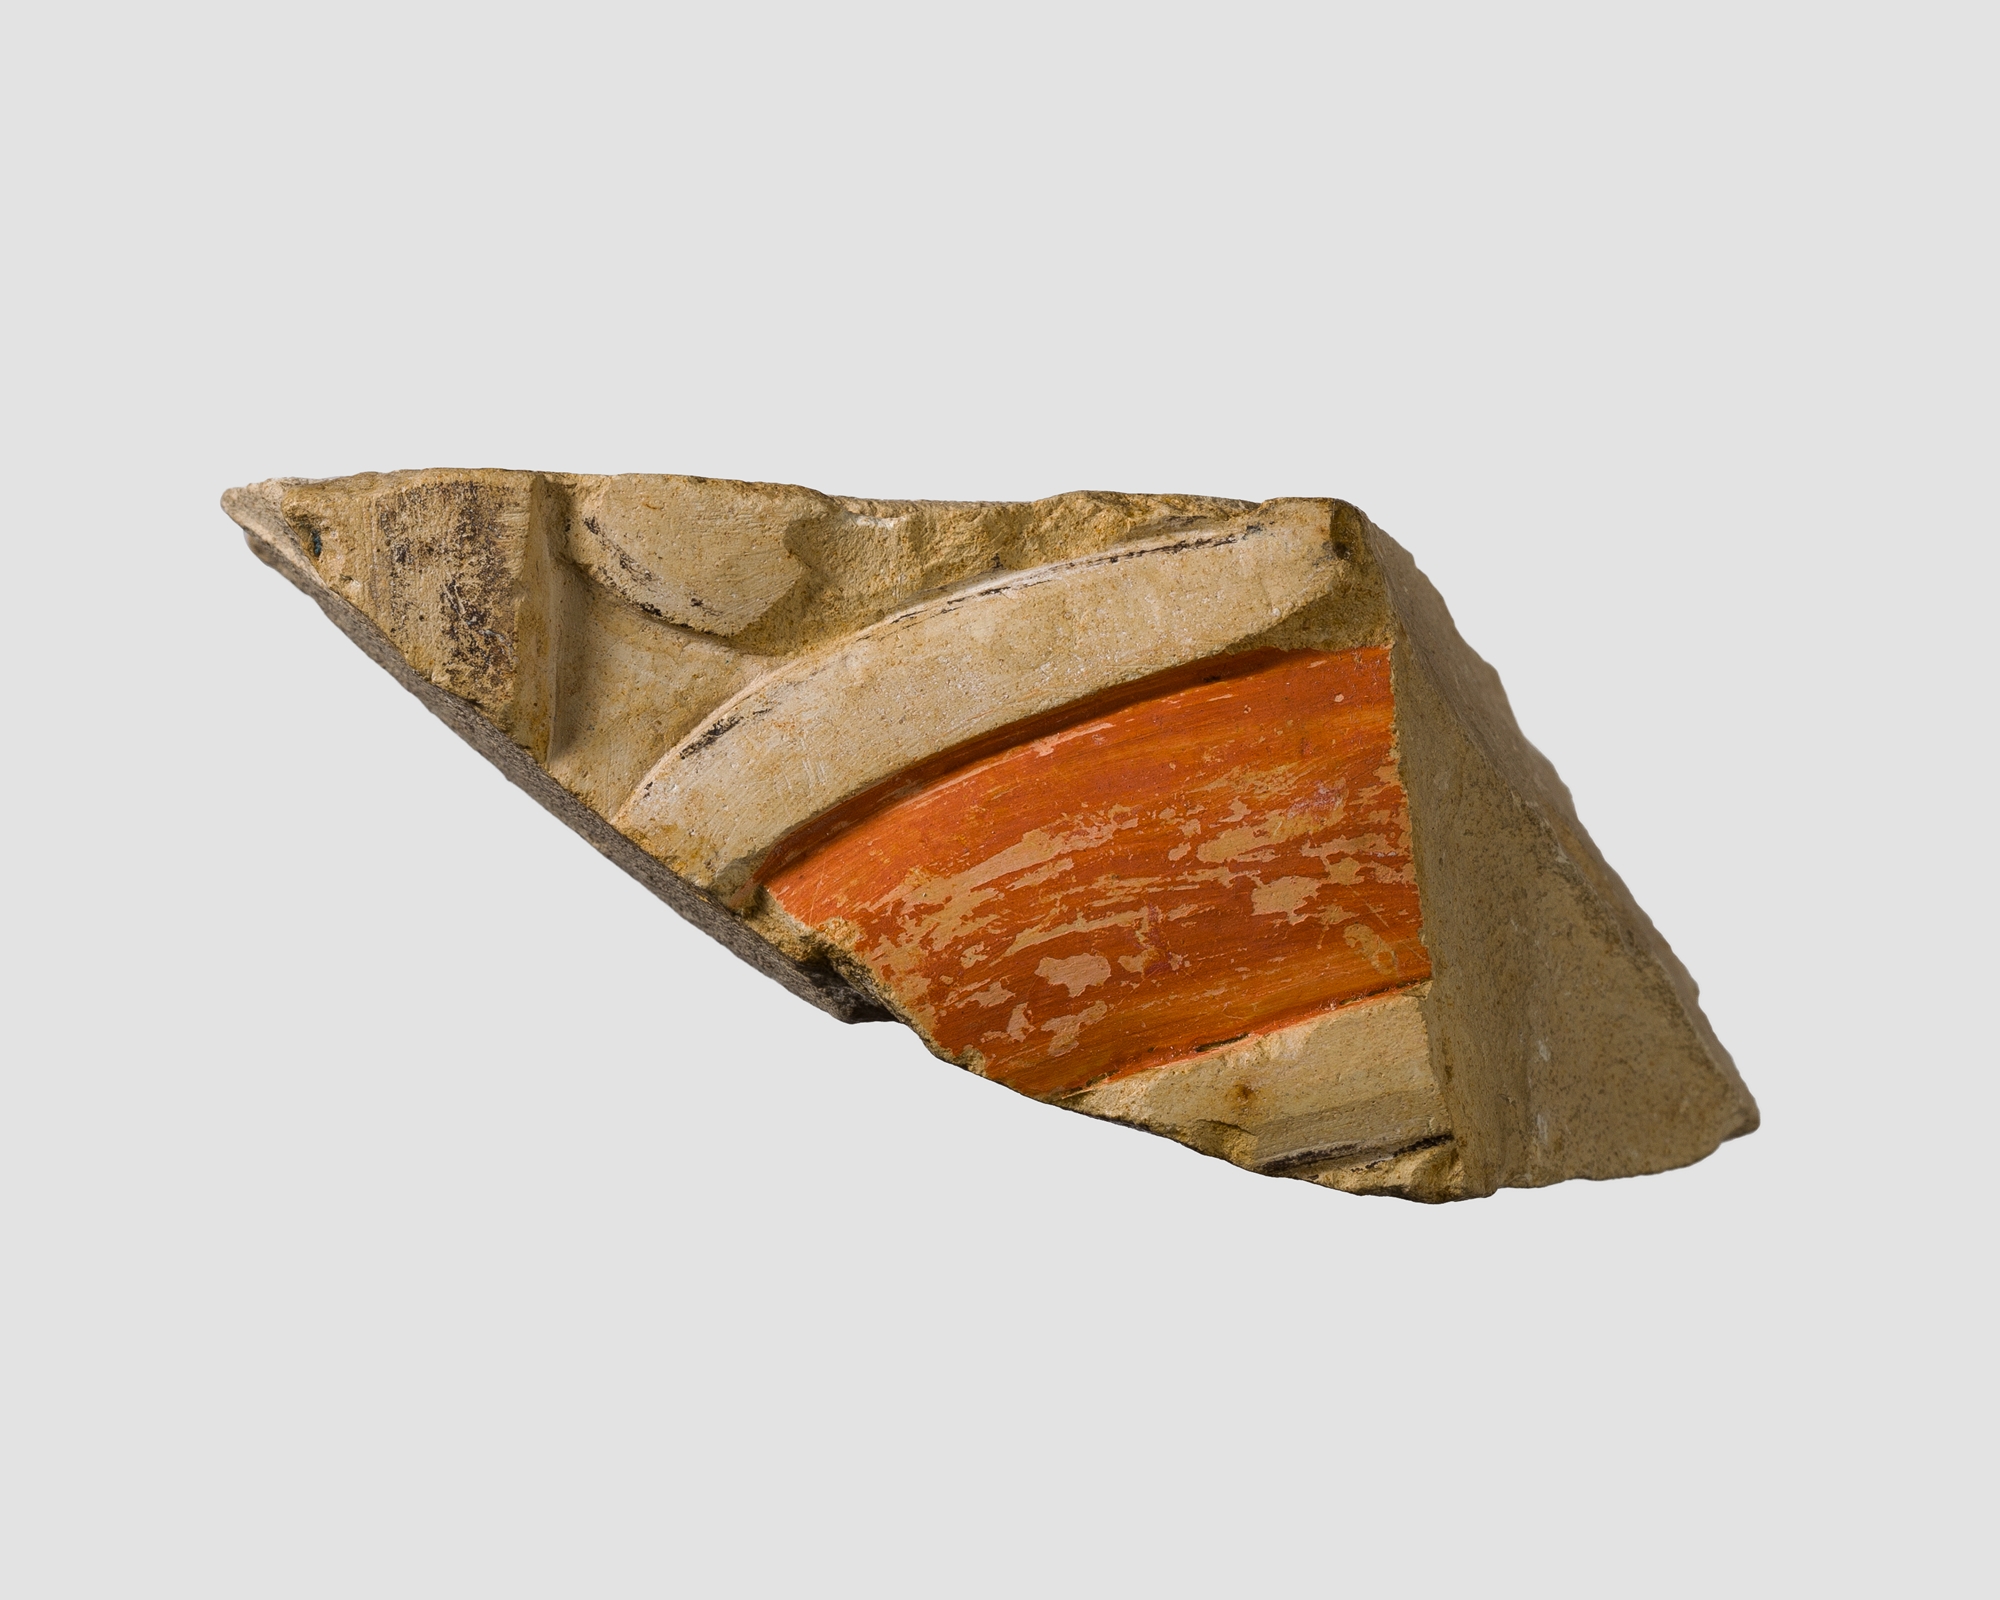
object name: relief fragment, neferu or khety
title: Relief fragment probably from the tomb of Khety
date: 2030-1640 BCE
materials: limestone, paint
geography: egypt